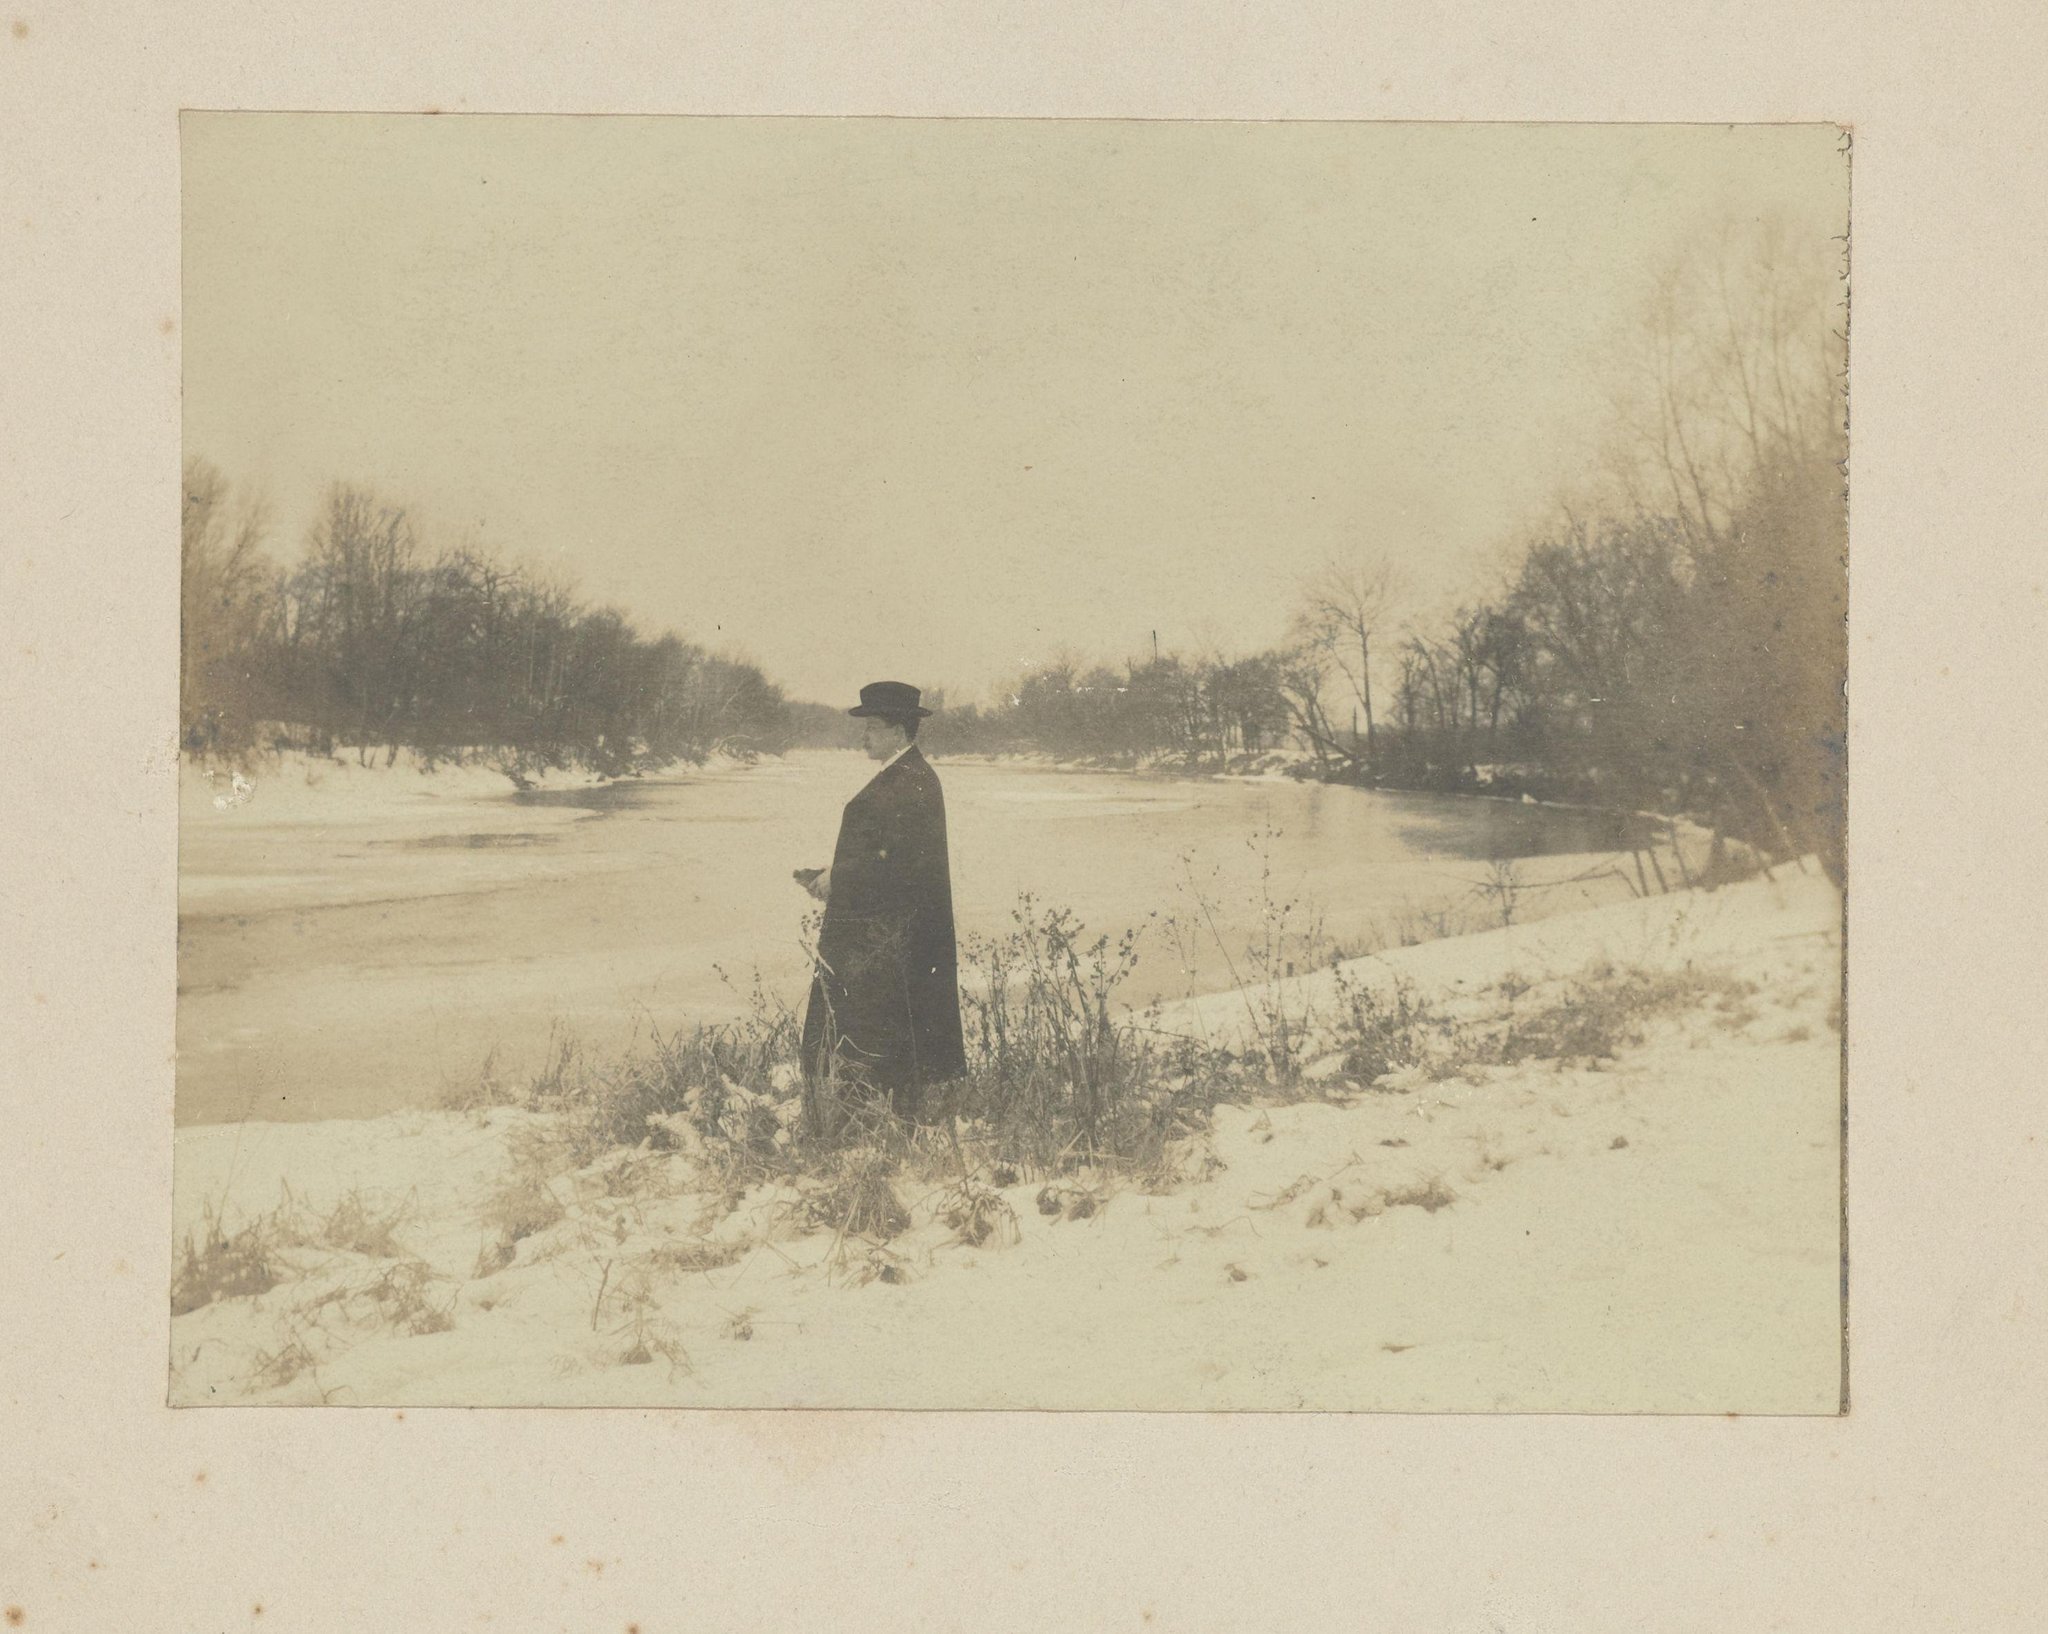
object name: photograph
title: Jan C. Schüller staand aan de oever van Meramec River tijdens de wereldtentoonstelling in St. Louis (Louisiana Purchase Exposition), 1904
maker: Anonymous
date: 1904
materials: cardboard, paper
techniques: gelatin silver print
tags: painter, print maker, draughtsman, jan schüller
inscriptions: annotation: ‘Jan C. Schüller’, annotation: ‘Meramec rivier // Noordwaarts gezien’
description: Jan C. Schüller staand aan de oever van Meramec River tijdens de wereldtentoonstelling in St. Louis (Louisiana Purchase Exposition), 1904.